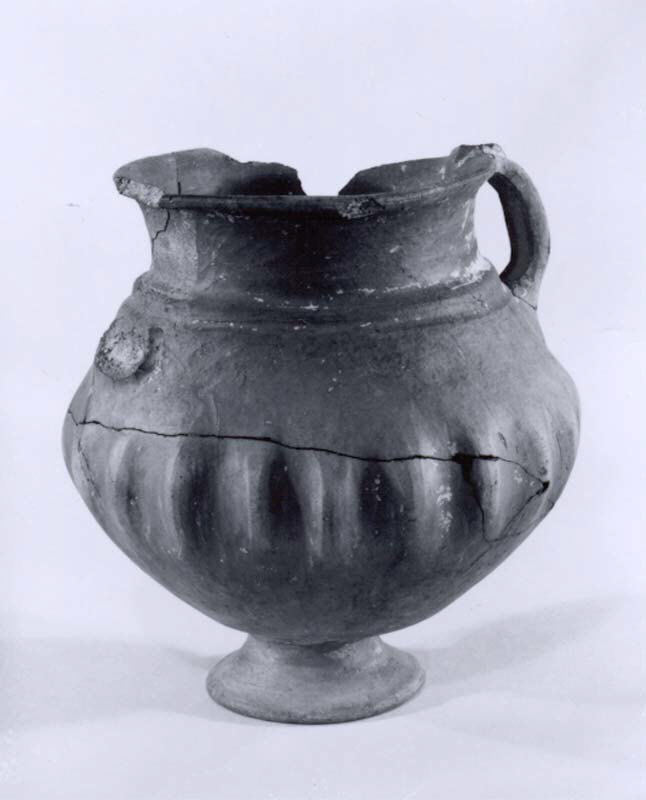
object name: jar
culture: iranian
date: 900-801 BCE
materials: ceramic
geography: iran